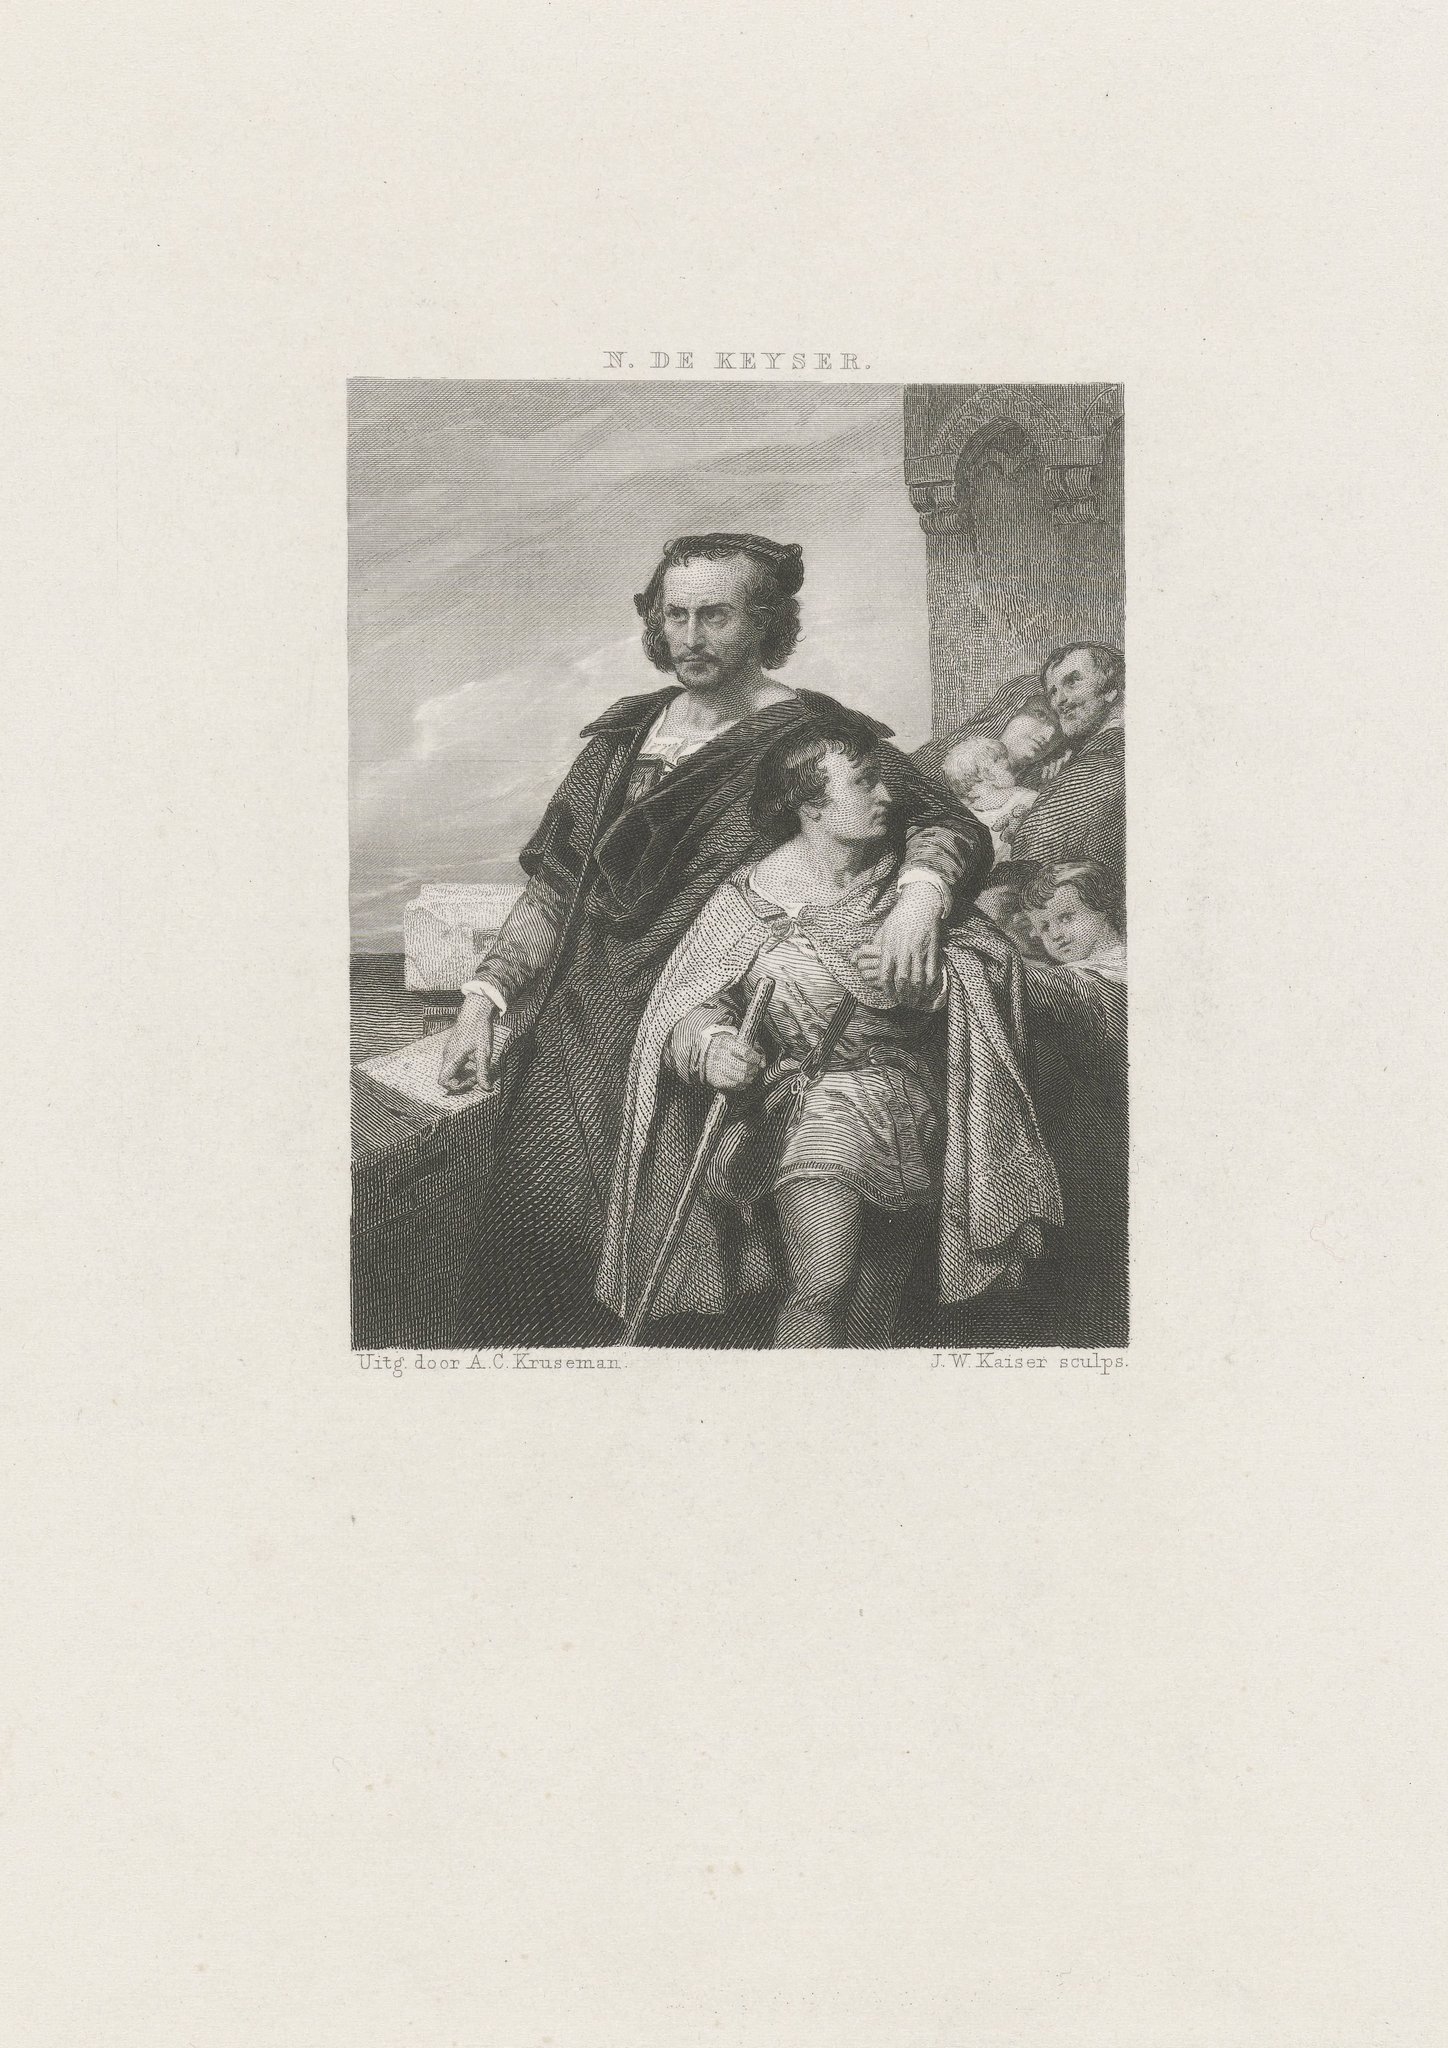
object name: print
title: Christoffel Columbus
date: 1859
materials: paper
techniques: etching, roulette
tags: genua, ontdekkingsreiziger, zeevaarder, christoffel columbus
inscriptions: inscription: ‘Columbus ... Aurora 1859’, collector's mark: Lugt 2228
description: Christoffel Columbus neemt een jongen mee onder zijn arm, terwijl een man, een vrouw en twee kleinere kinderen, mogelijk het gezin van de jongen, achterblijven.